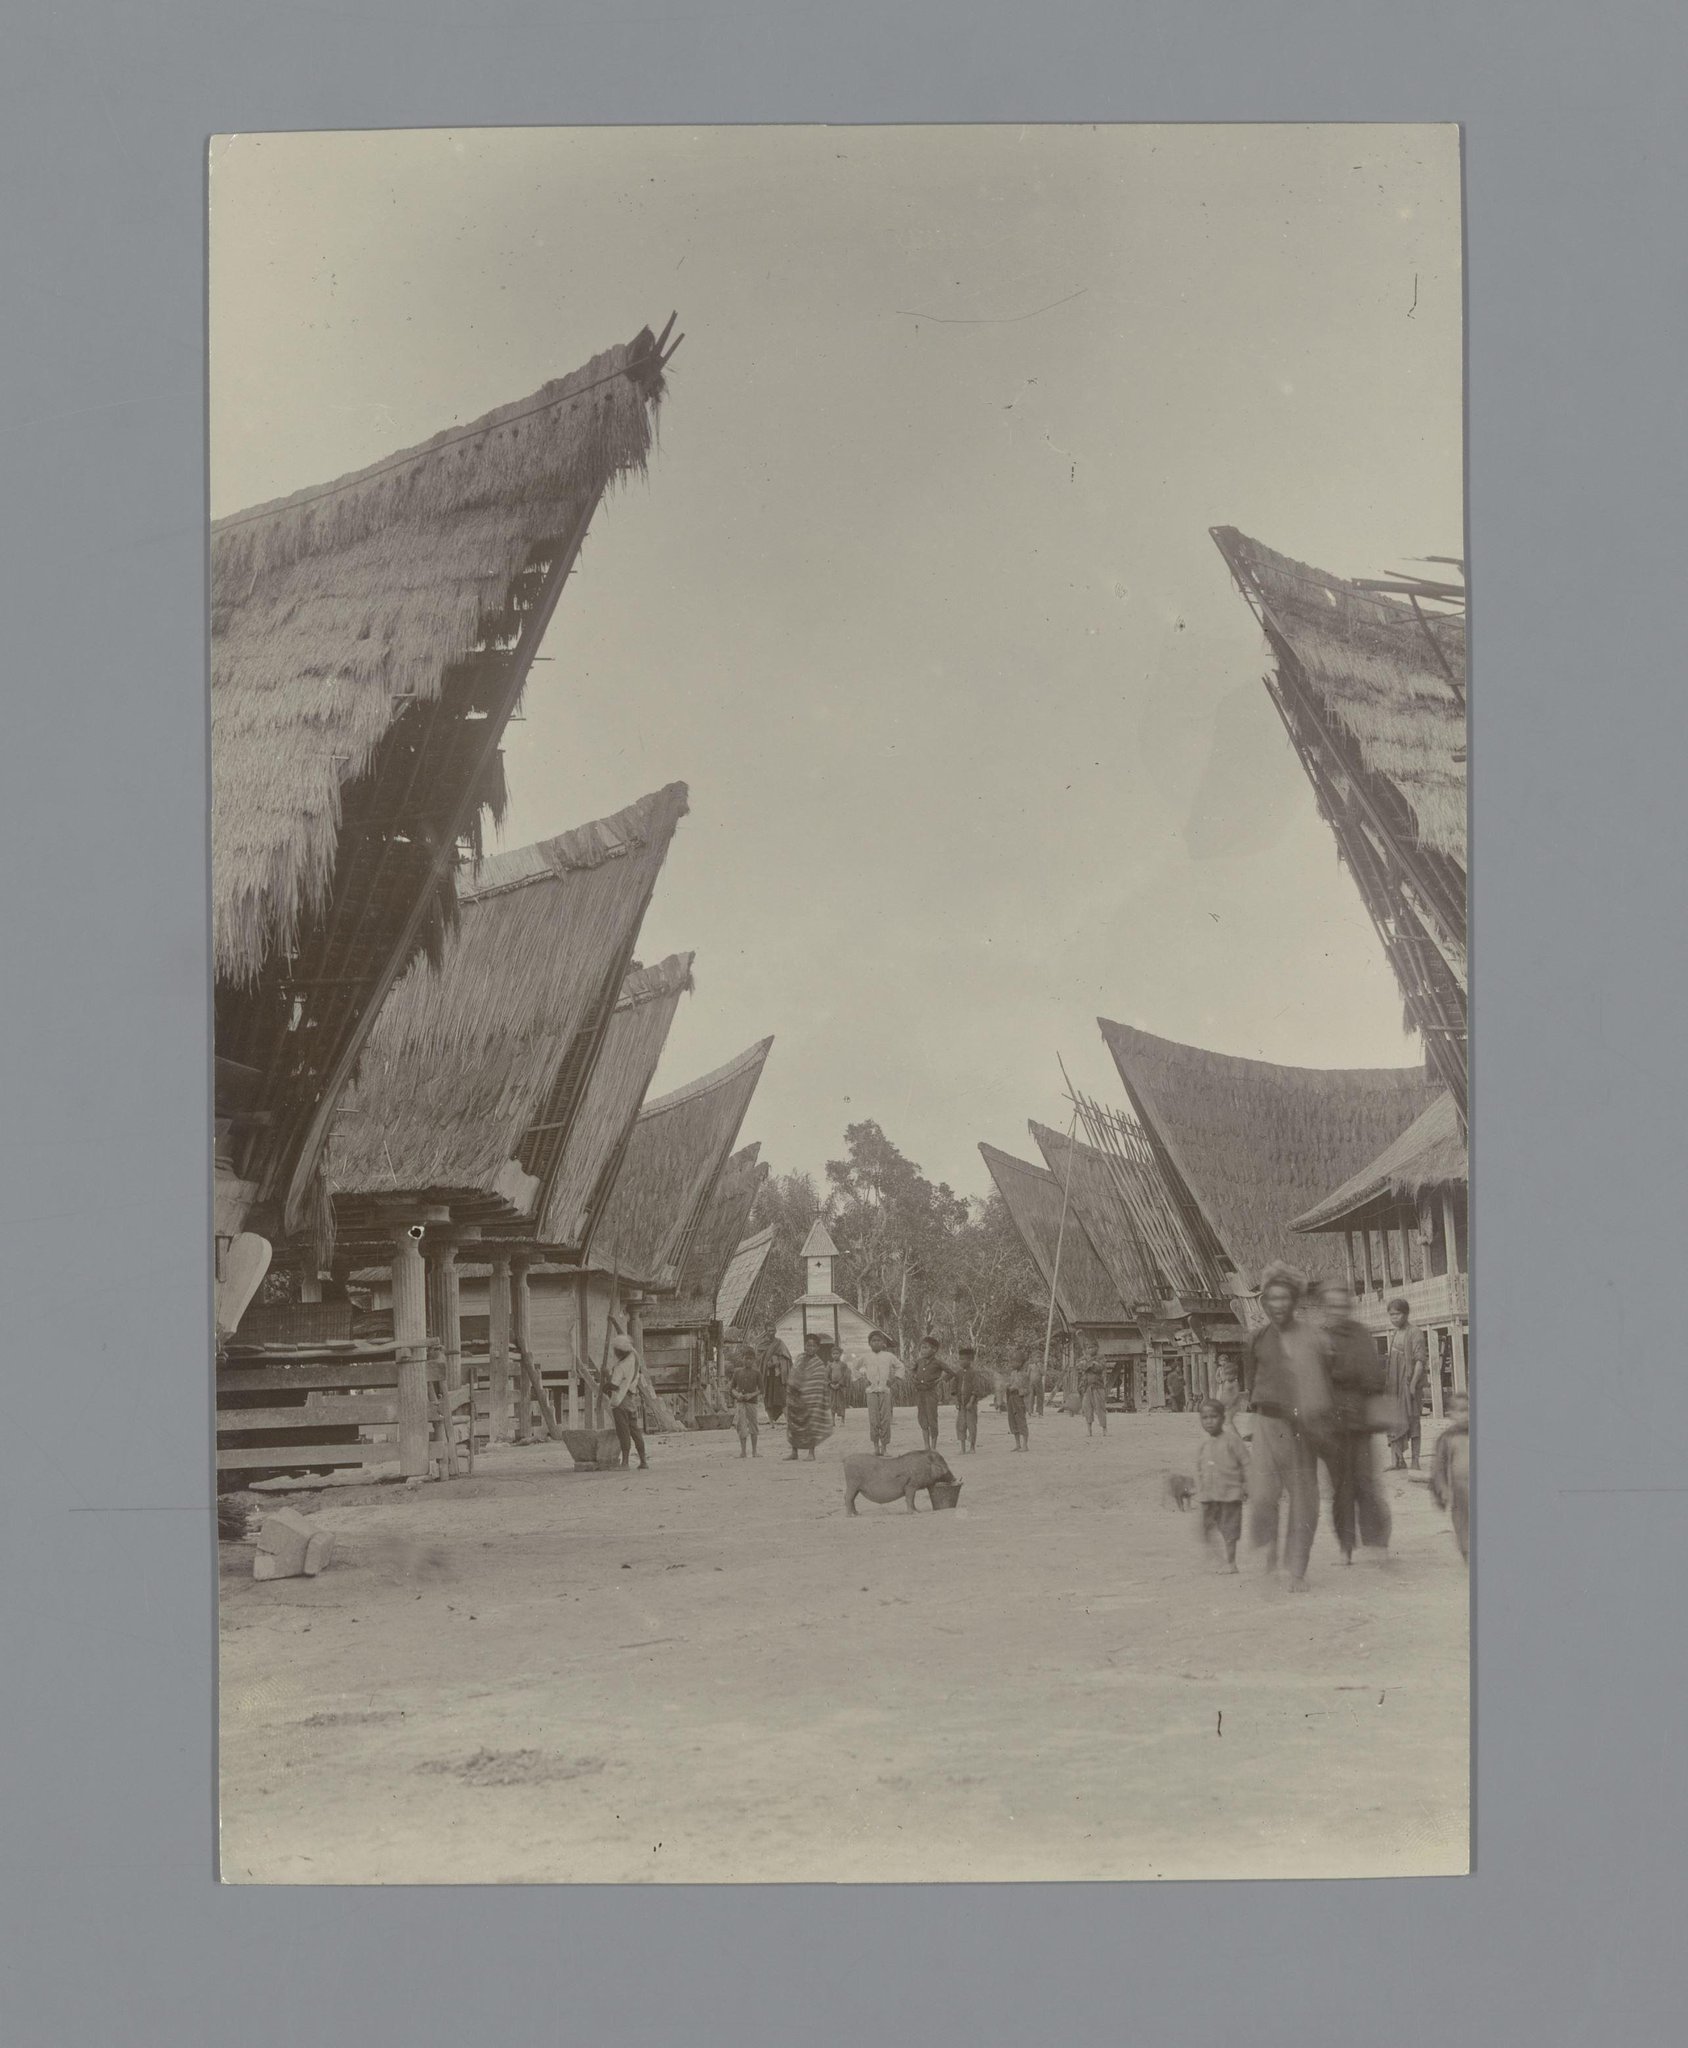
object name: photograph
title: Batakdorp op Sumatra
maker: Anonymous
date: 1880-1910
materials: paper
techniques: collodion silver print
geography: sumatra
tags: village, sumatra